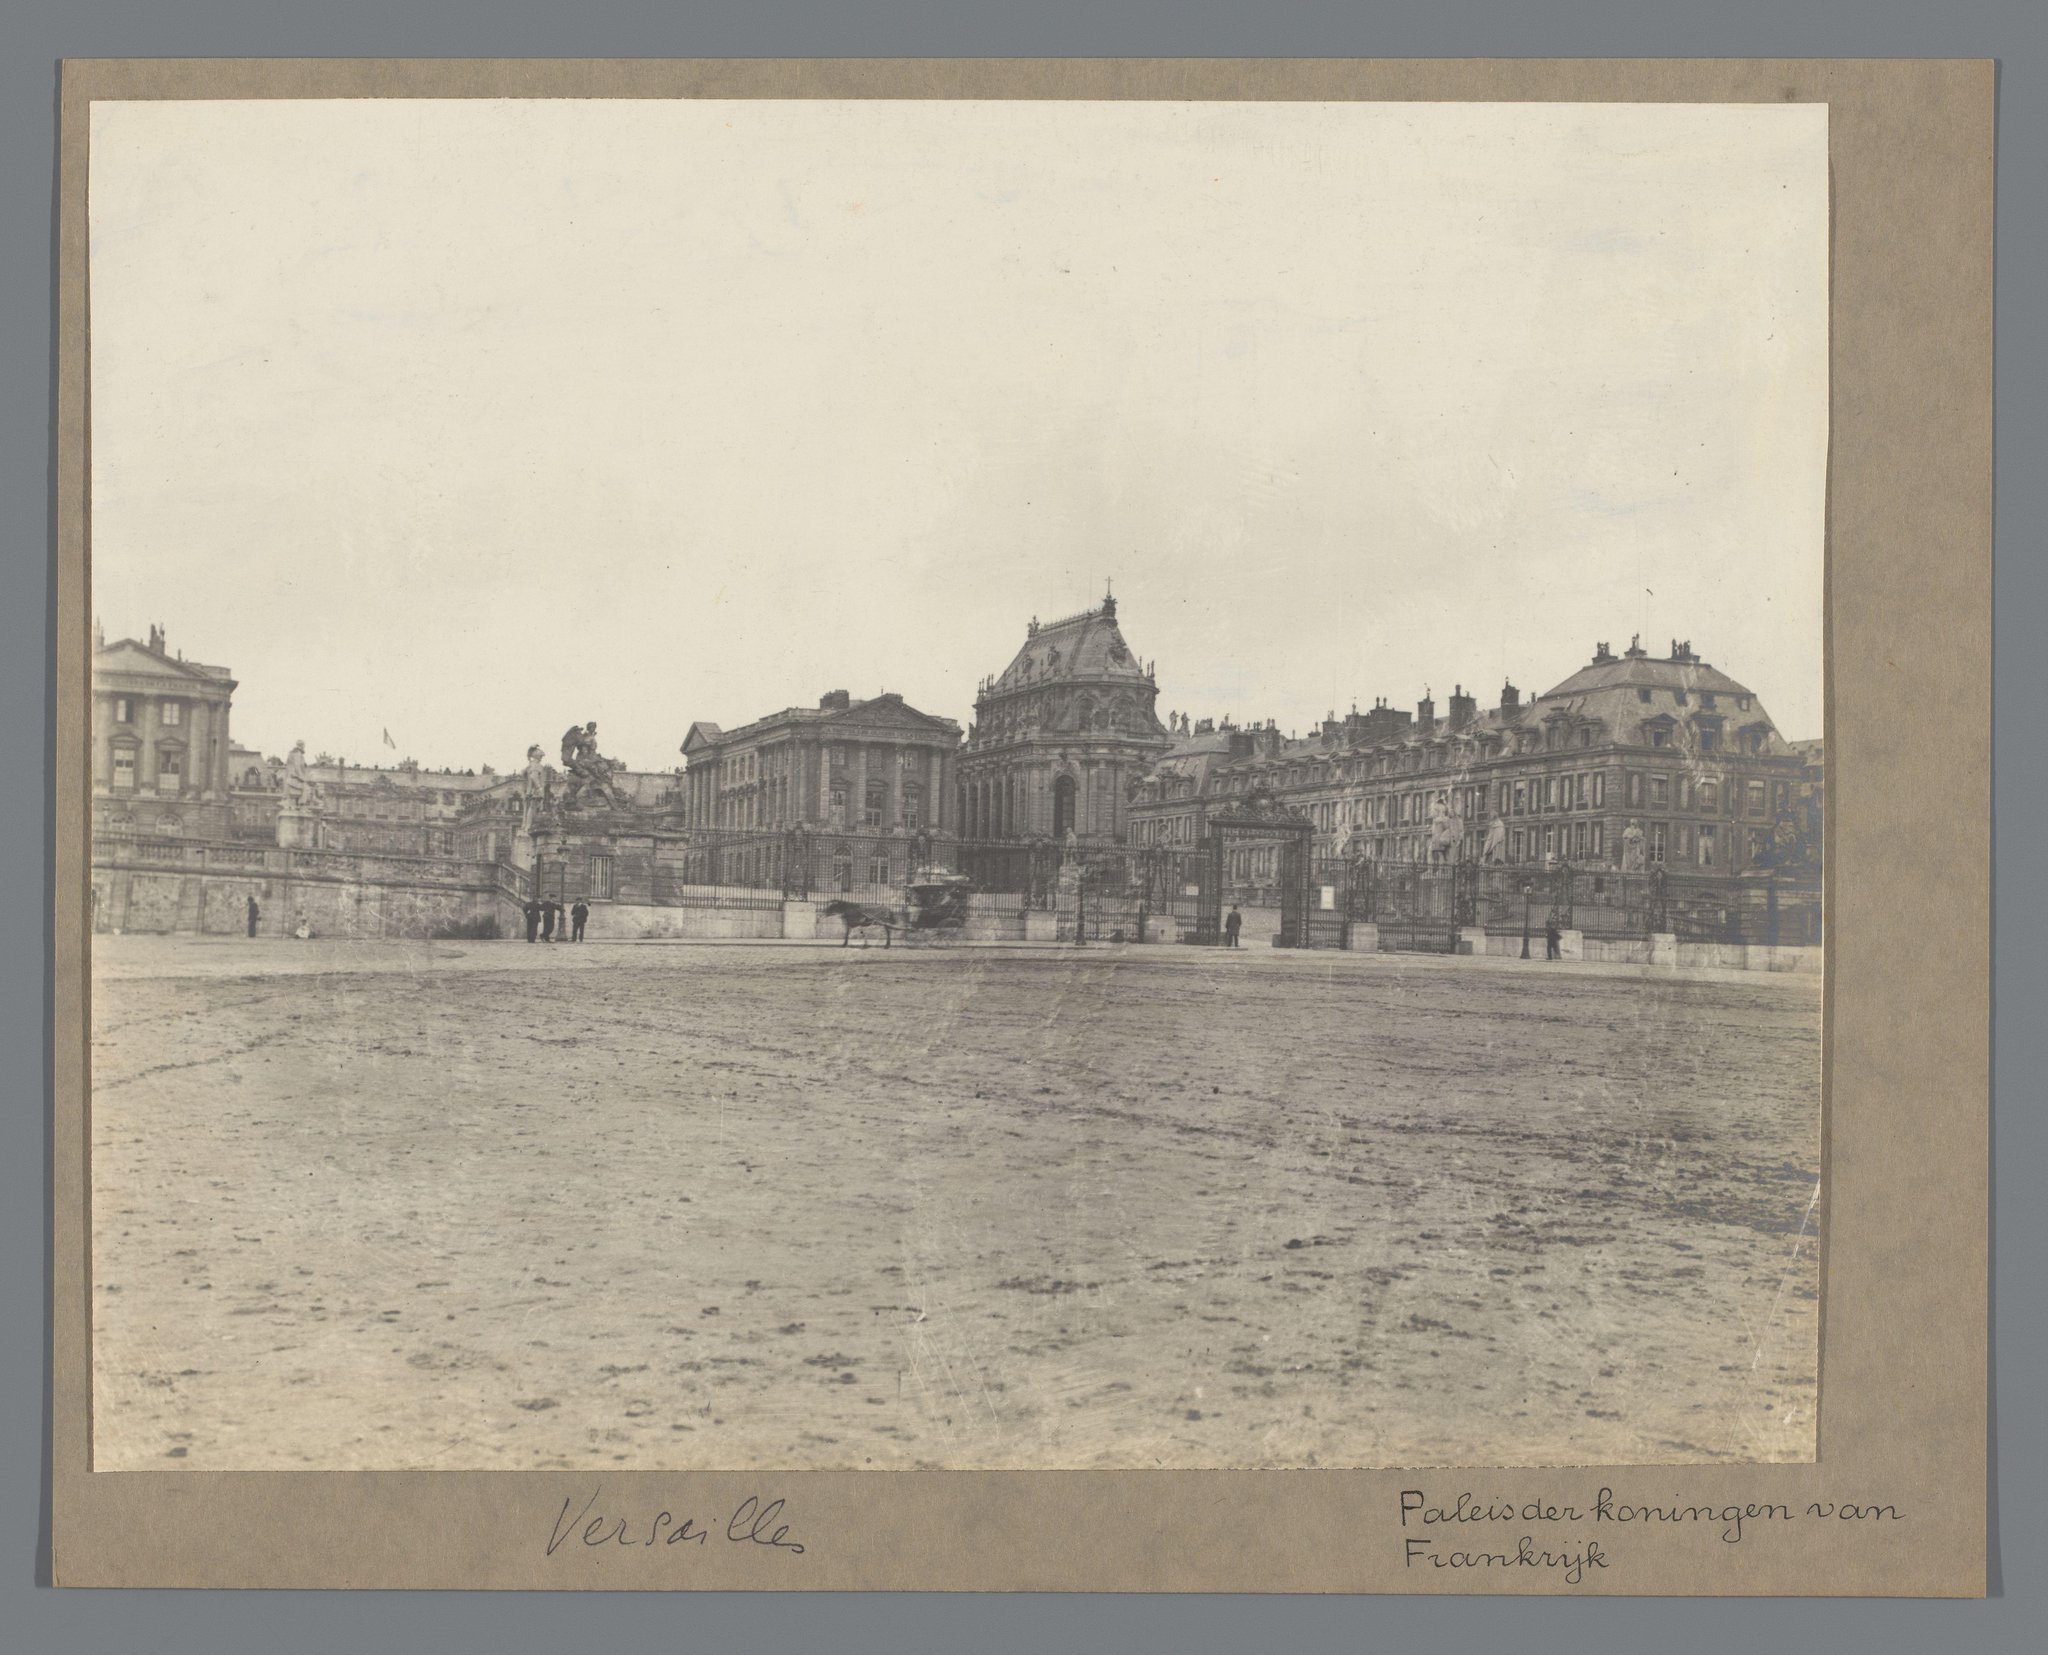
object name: photograph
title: Versailles. Palais der Koningen van Frankrijk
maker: Anonymous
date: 1880-1930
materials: photographic support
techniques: gelatin silver print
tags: kasteel van versailles